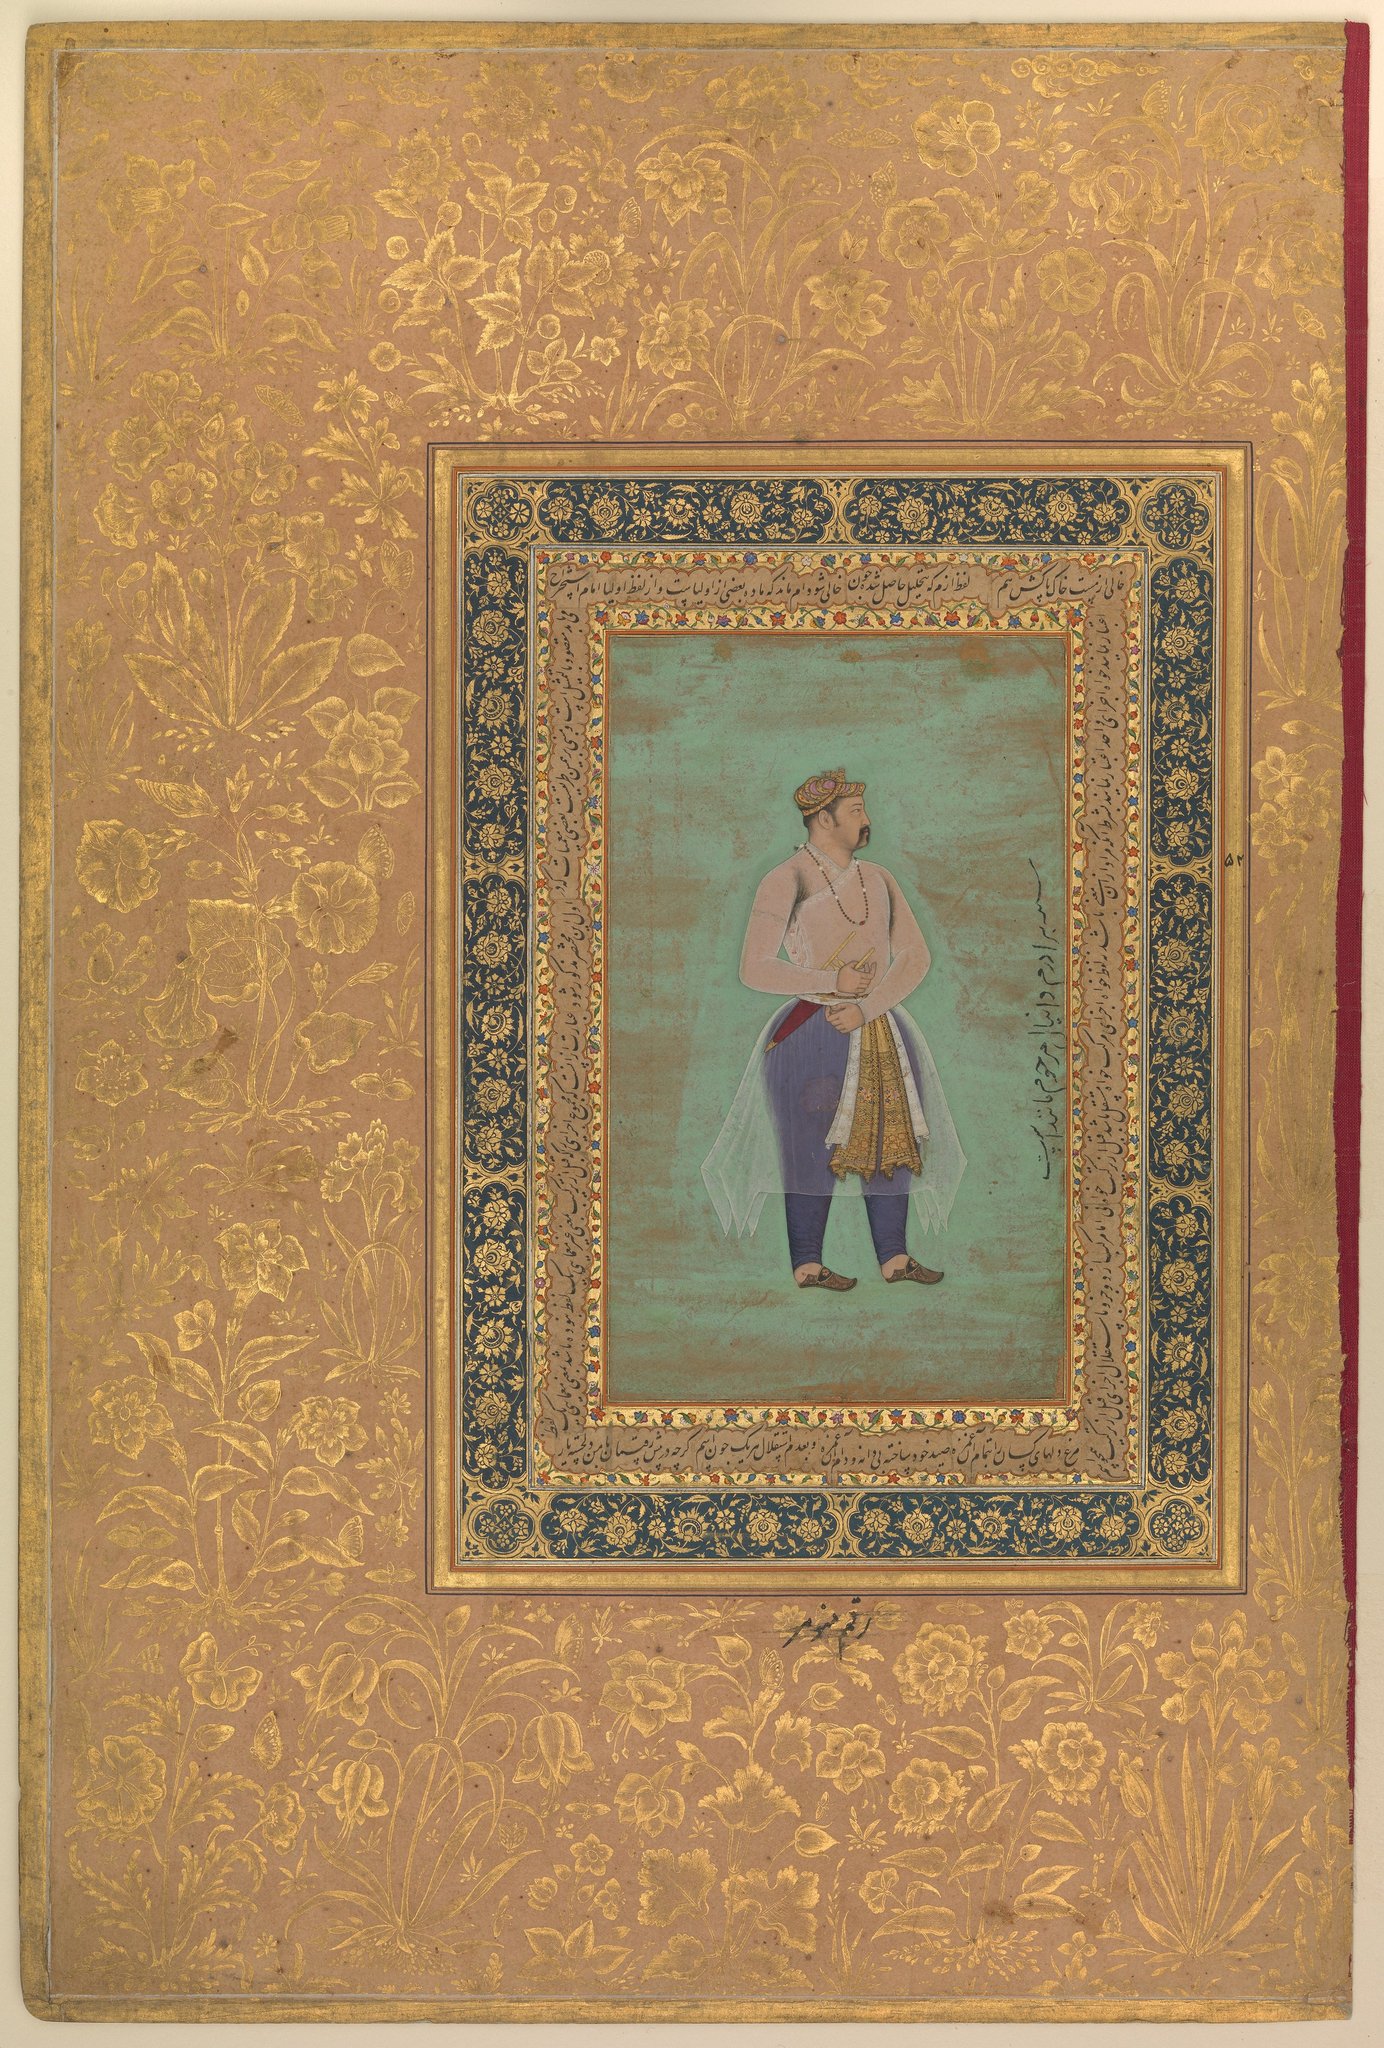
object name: album leaf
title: recto: "Portrait of Prince Danyal", Folio from the Shah Jahan Album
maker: manohar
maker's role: artist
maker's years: 1577-1624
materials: gold, ink, paper, watercolor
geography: india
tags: princes,men,portraits